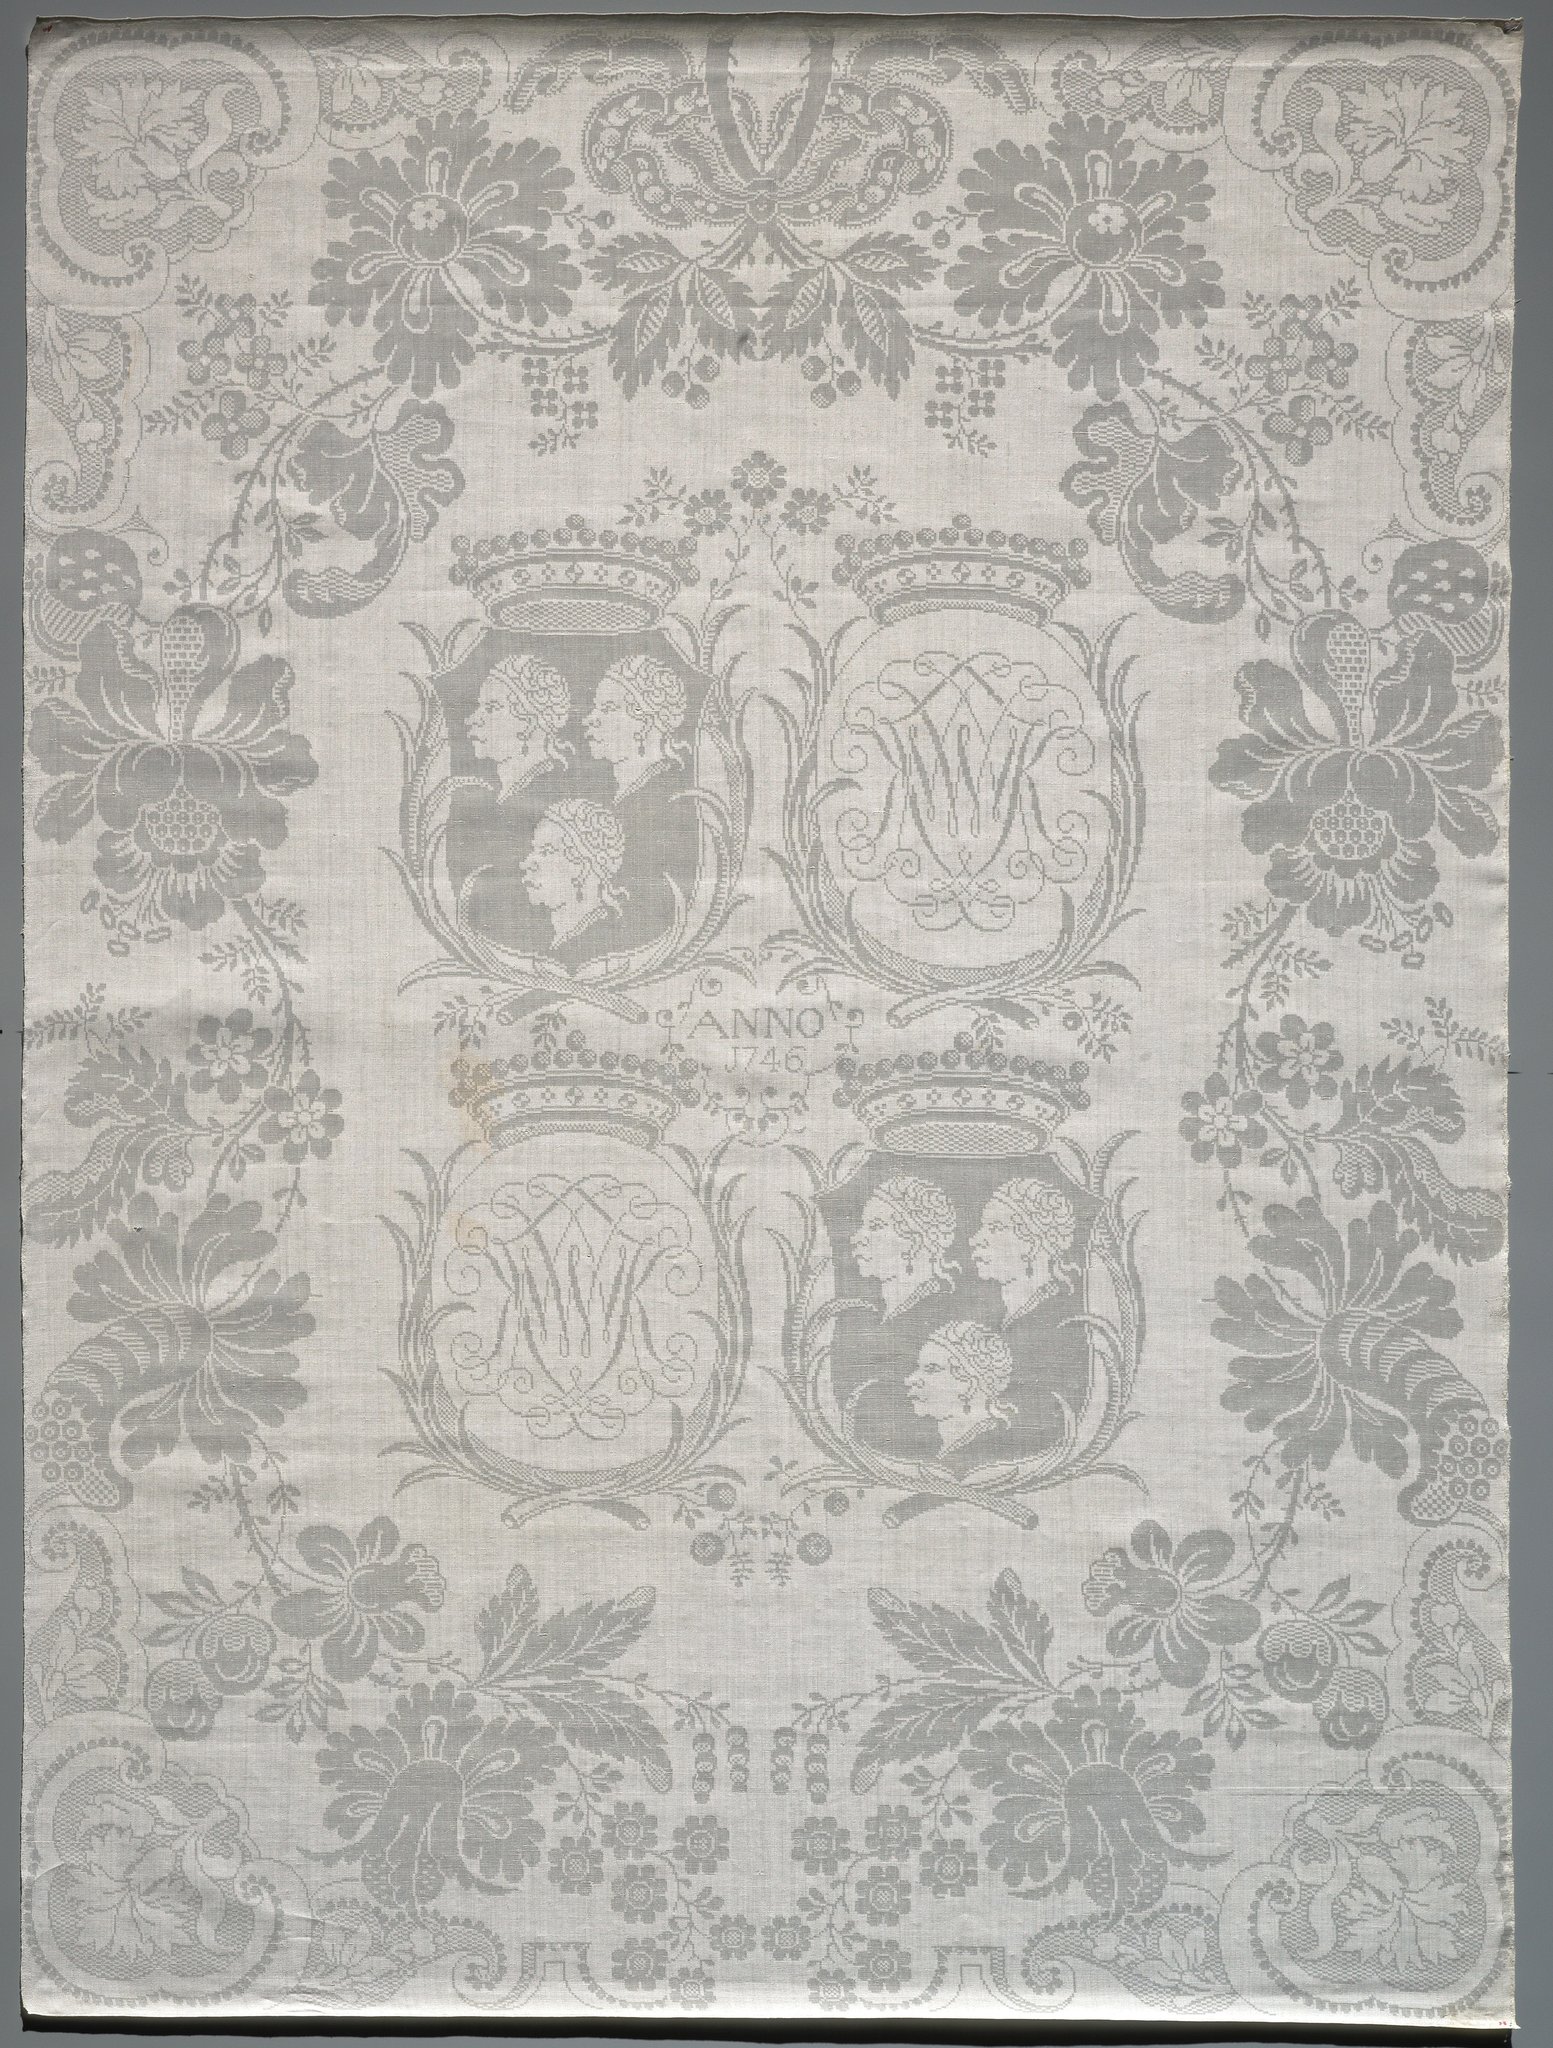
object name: woven material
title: Servet van wit linnendamast, bloementakken en rococo-ornament, tweemaal het gekroonde wapen Kops en tweemaal het spiegelmonogram NWK, in het hart ANNO 1746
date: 1746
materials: linen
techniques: damask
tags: nicolaas willem kops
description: Servet van wit linnendamast, bloementakken en rococo-ornament, tweemaal het gekroonde wapen Kops en tweemaal het spiegelmonogram NWK, in het hart ANNO 1746; vervaardigd voor Nicolaas Willem Kops (1719-1778) in het jaar van zijn huwelijk (8 maart 1746) met Elisabeth Barnaart (1715-1771).